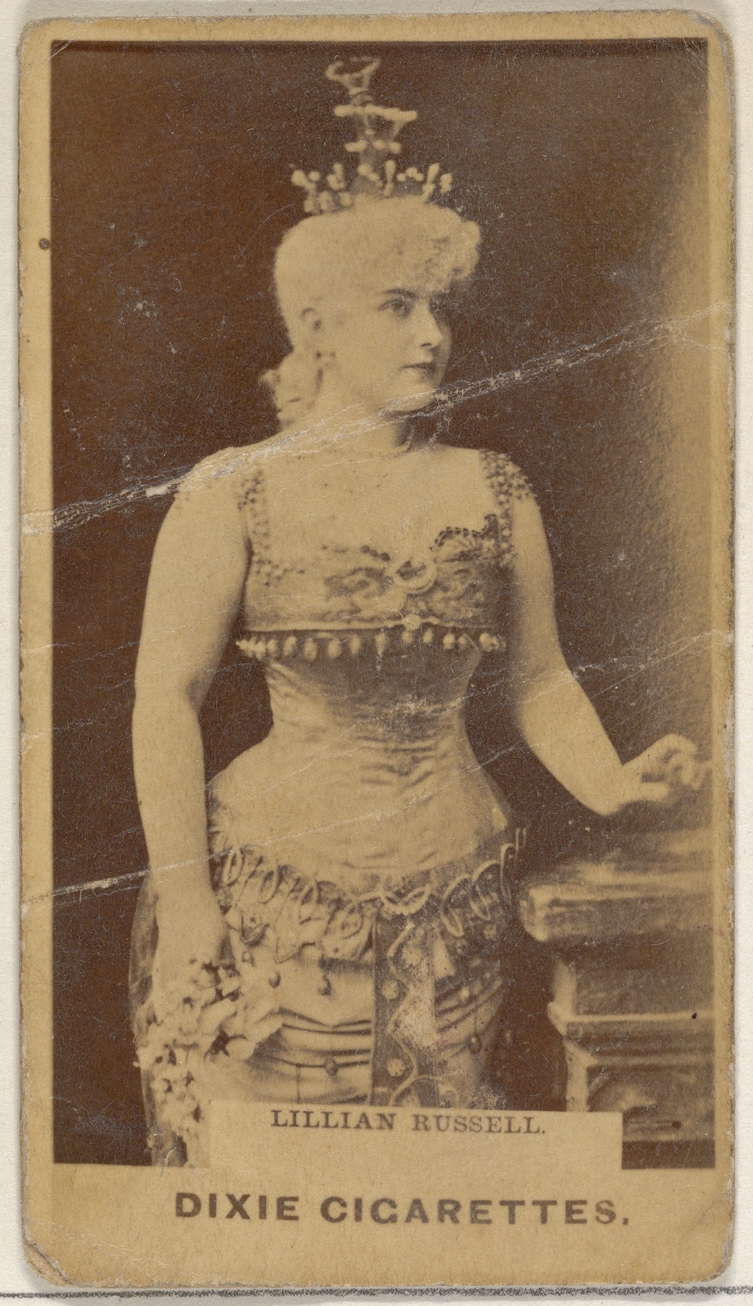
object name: photograph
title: Lillian Russell, from the Actors and Actresses series (N45, Type 7) for Dixie Cigarettes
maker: allen & ginter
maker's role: publisher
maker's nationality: american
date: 1888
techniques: albumen silver print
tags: portraits,women,actresses